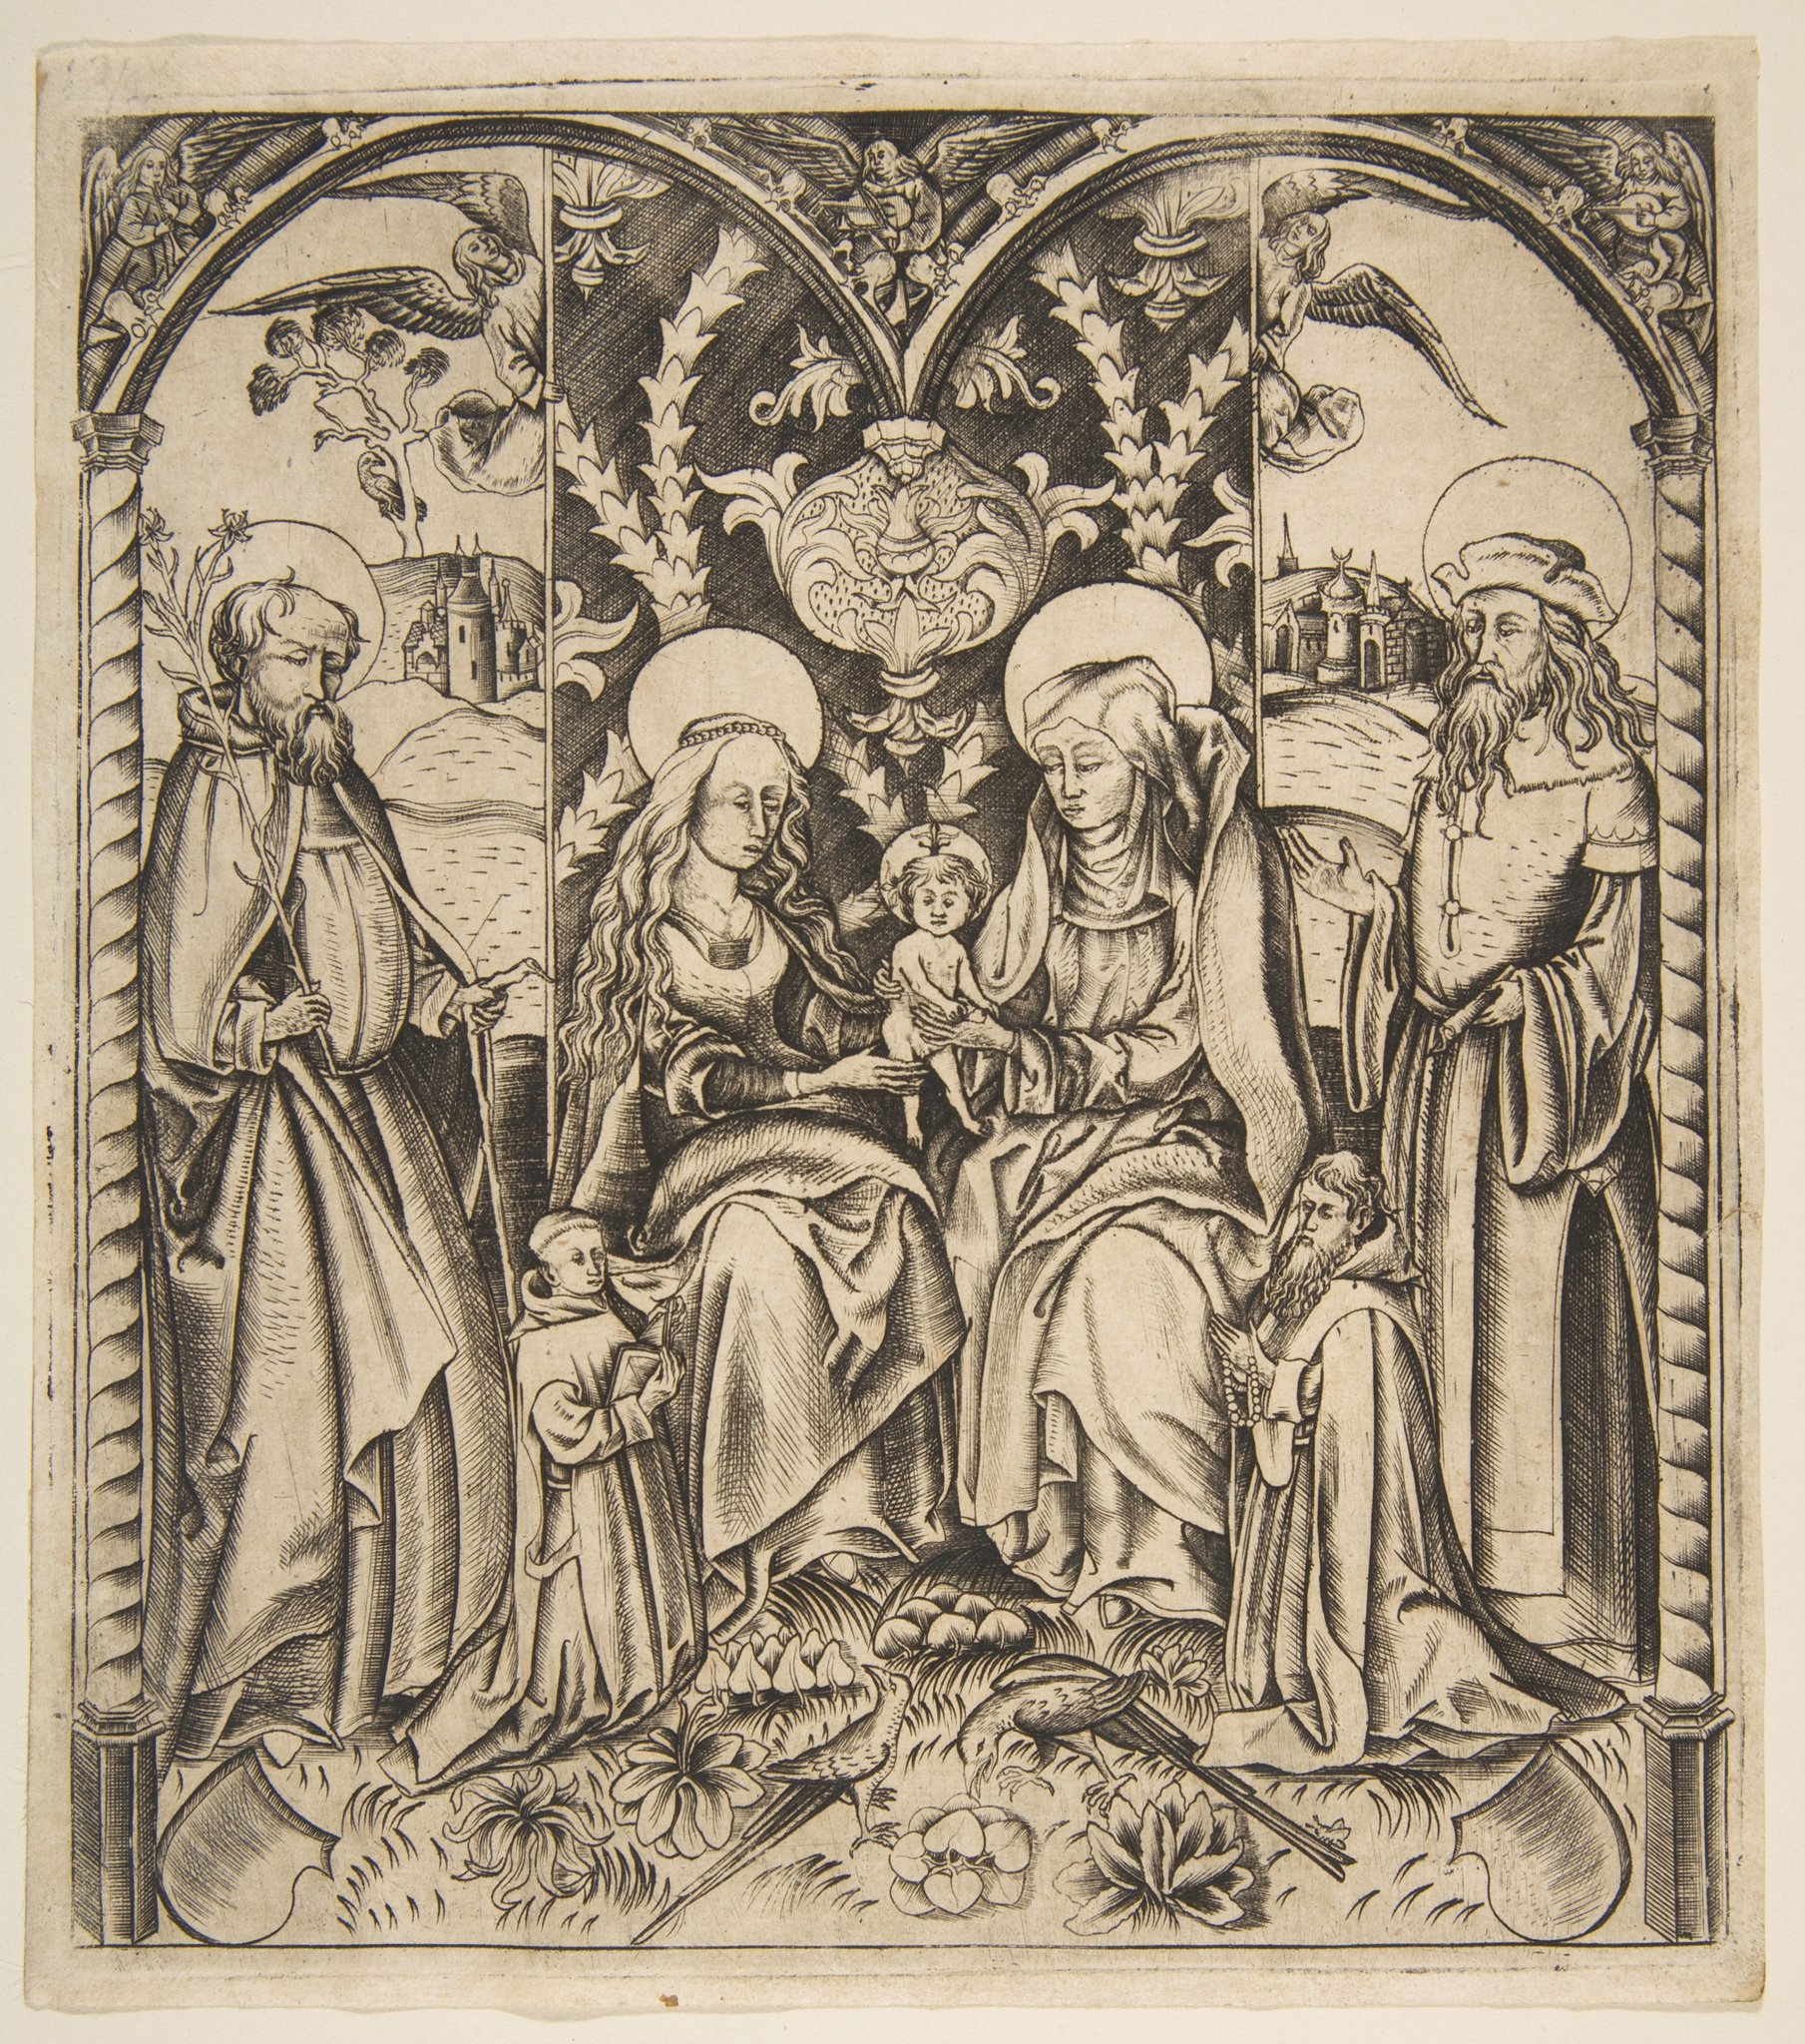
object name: print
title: The Holy Family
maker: anonymous, german, 15th century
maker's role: artist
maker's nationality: german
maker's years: 1400-1500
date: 1401-1500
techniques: engraving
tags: holy family